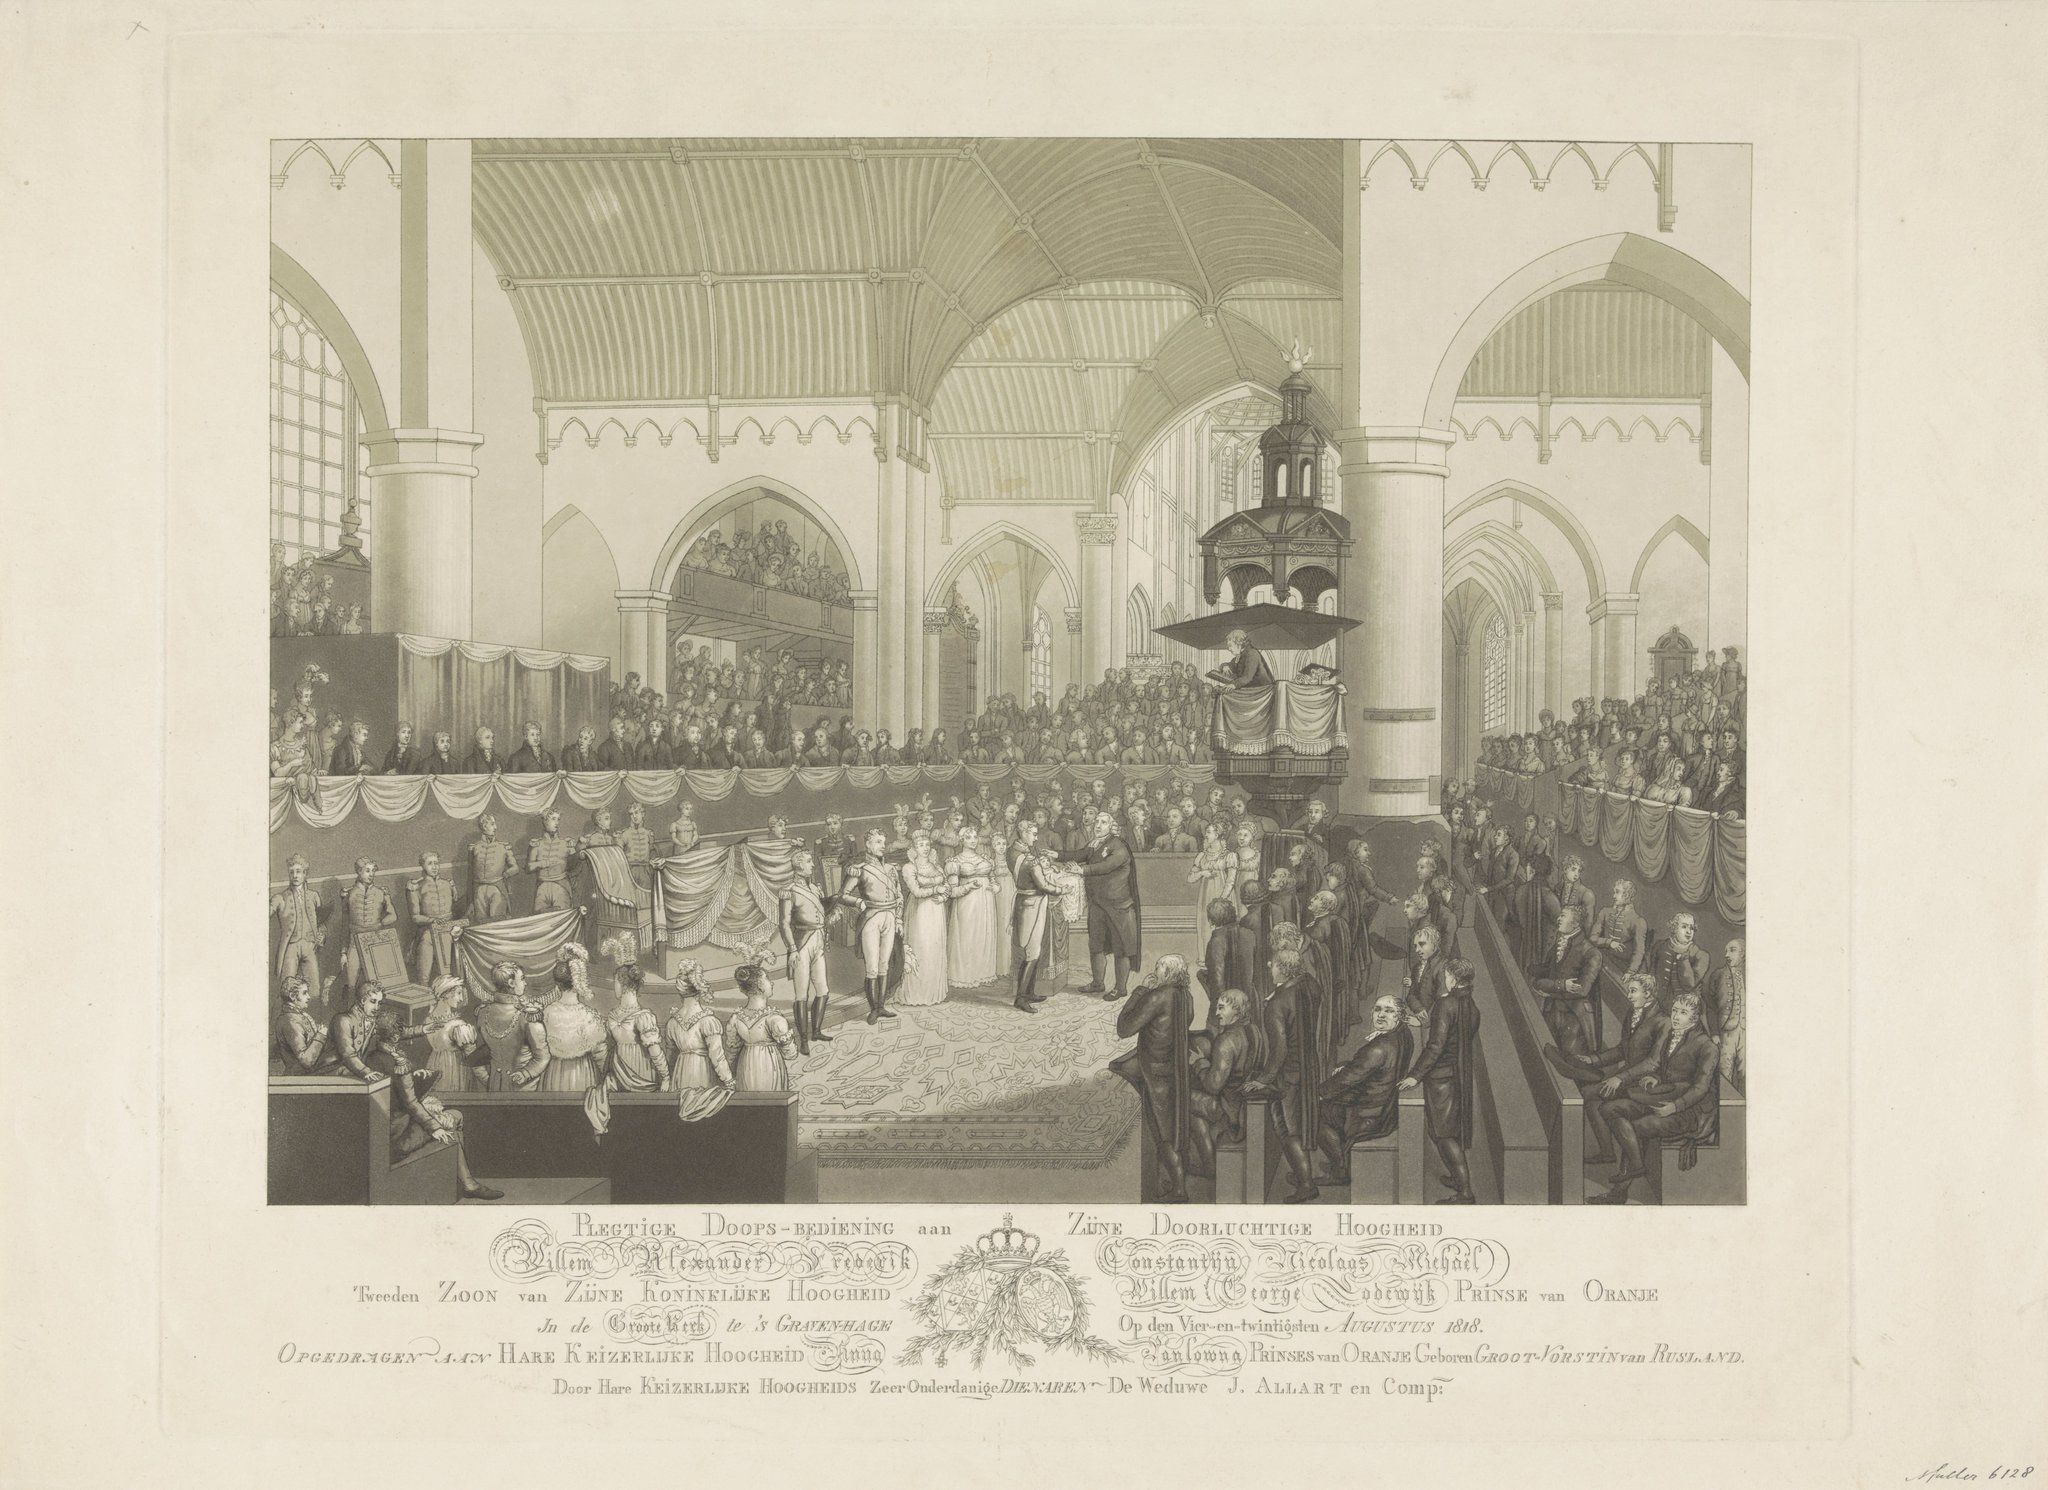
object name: print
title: Plechtige Doops-bediening aan Zijne Doorluchtige Hoogheid Willem Alexander Frederik Constantijn Nicolaas Michaël Tweeden Zoon (...) In de Groote Kerk te 's Graven-hage Op den Vier-en-twintigsten Augustus 1818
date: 1818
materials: paper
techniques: aquatint, etching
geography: netherlands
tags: anna paulowna romanowa, william i of the netherlands, the hague, william ii of the netherlands, alexander (prins der nederlanden, prins van oranje-nassau), frederik (prins der nederlanden), berlin, voorburg, marianne (prinses der nederlanden), wilhelmina frederica louisa (koningin der nederlanden), baptism ~ protestant service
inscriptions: collector's mark: Lugt 2228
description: Doopplechtigheid van prins Alexander van Oranje-Nassau, de tweede zoon van Willem II en Anna Paulowna, in de Grote Kerk te Den Haag op 24 augustus 1818. In het midden van de kerk staan koning Willem I, prins Frederik, prinses Anna Paulowna, koningin Wilhelmina van Pruisen, prinses Marianne en de kroonprins, de vader en de latere koning Willem II, die het kind ten doop houdt. De doop wordt bediend door hofkapelaan ds. Krieger. De kerk verder gevuld met genodigden.